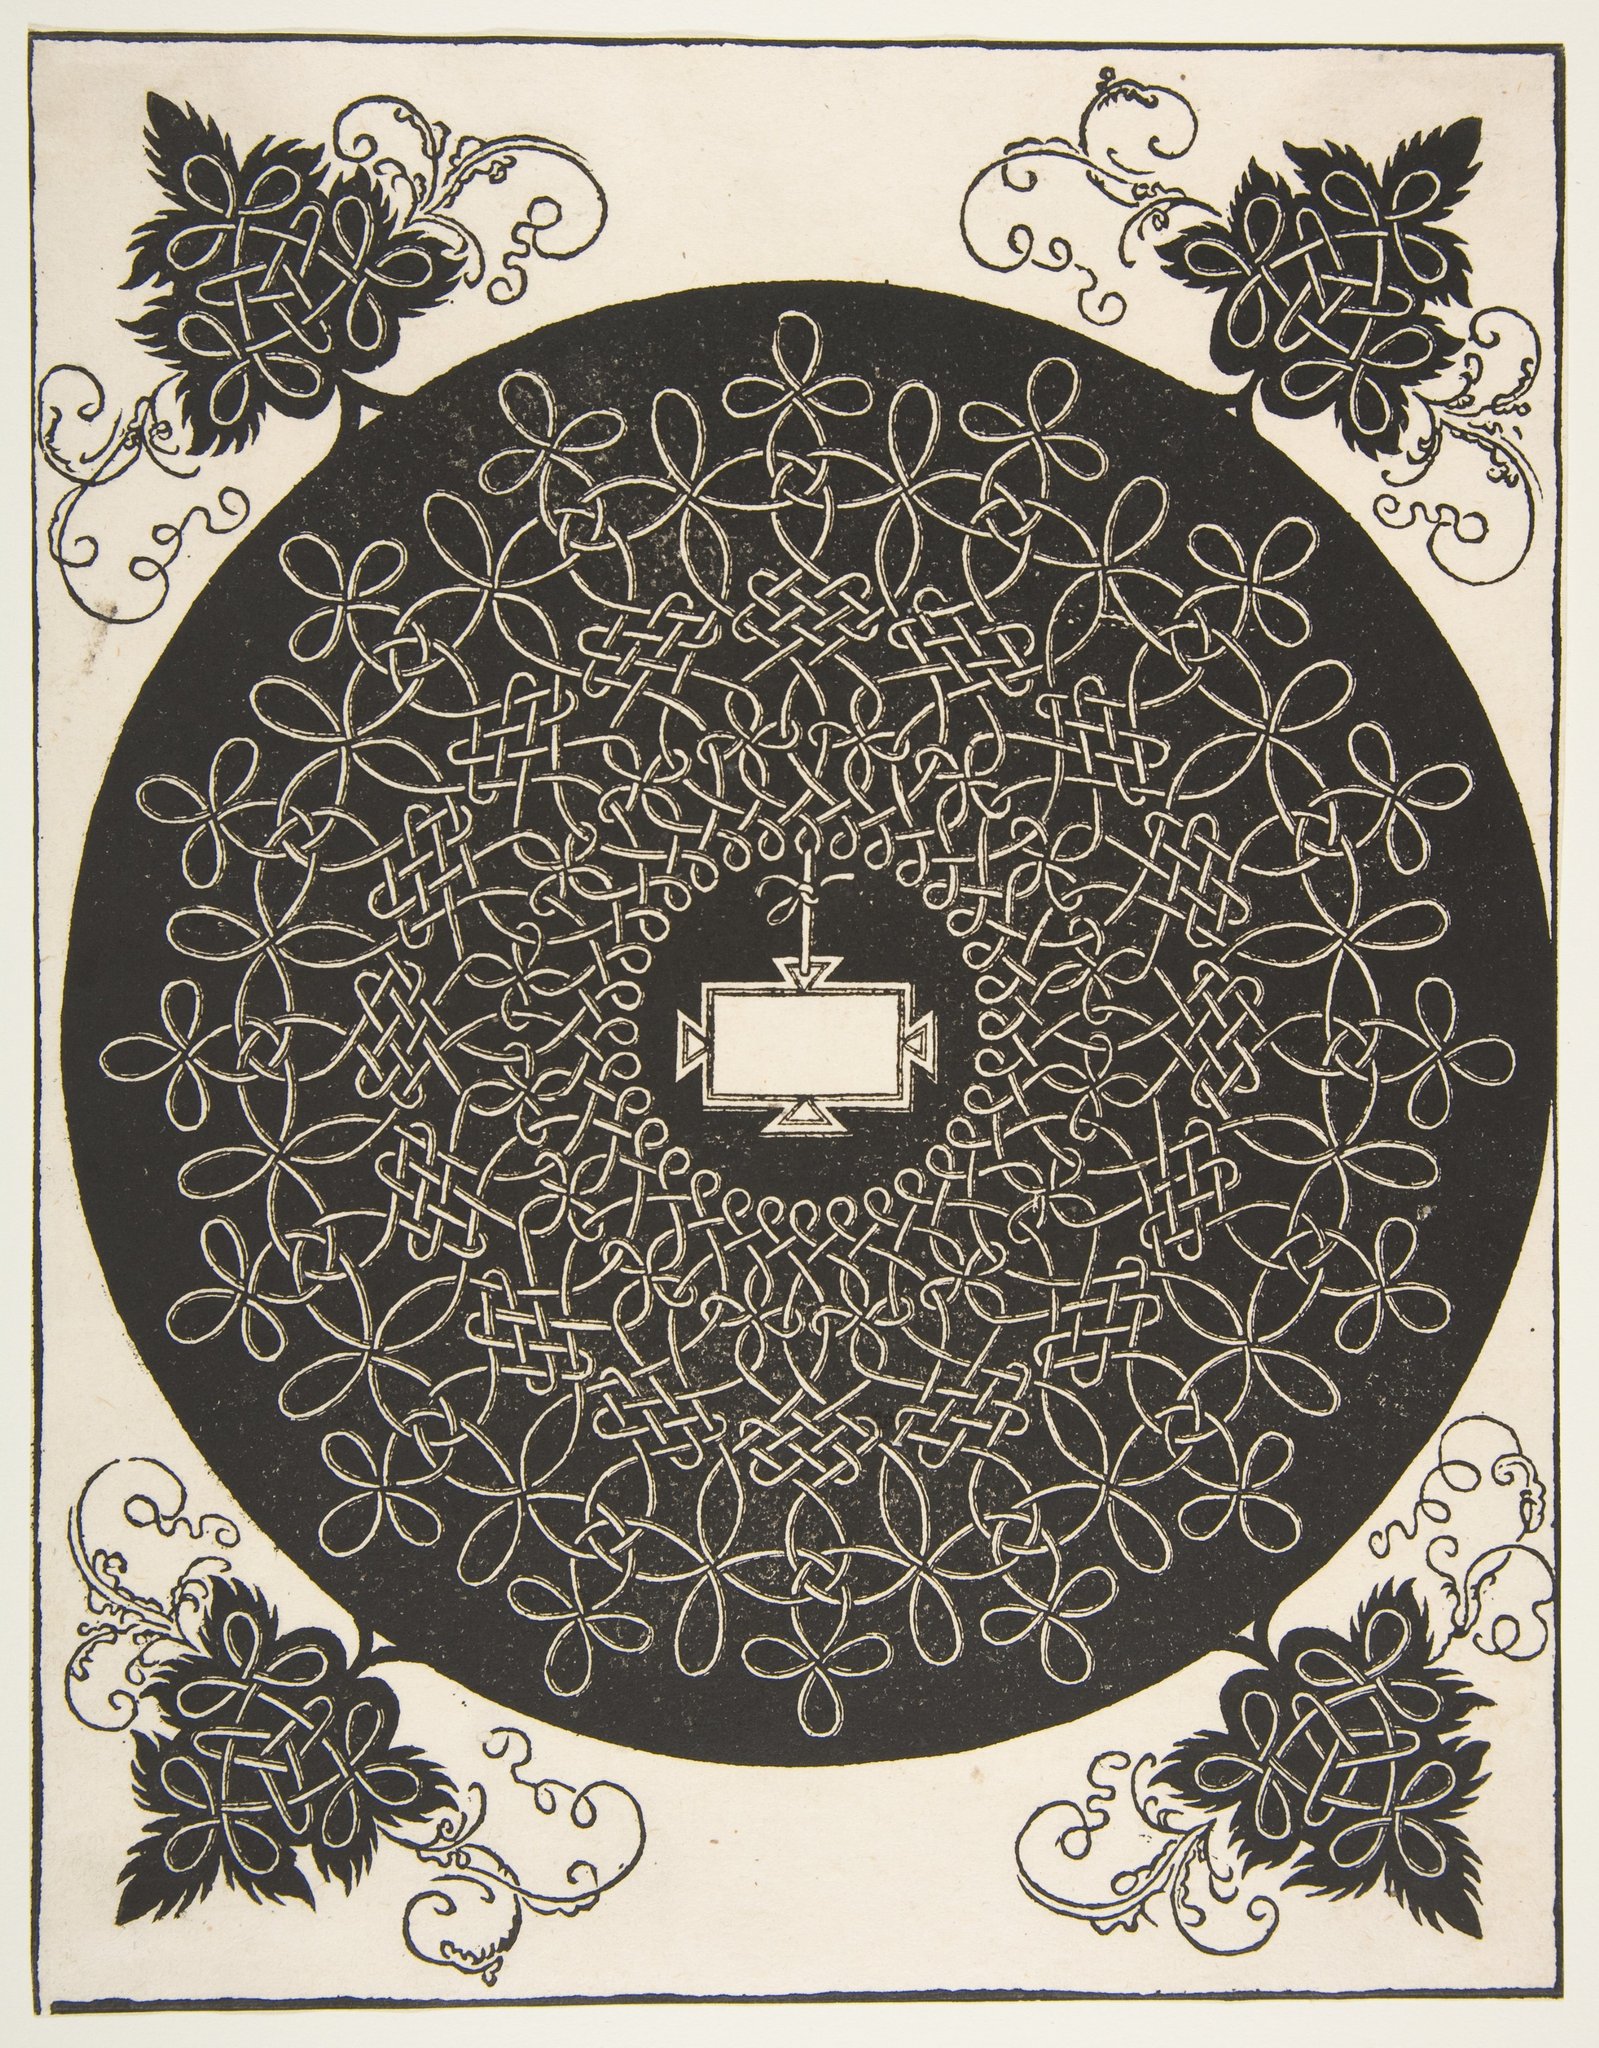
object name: collection ornament architecture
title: “The First Knot”. Interlaced Roundel with an Oblong Panel in its Center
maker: albrecht dürer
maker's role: artist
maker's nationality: german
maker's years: 1471-1528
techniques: woodcut